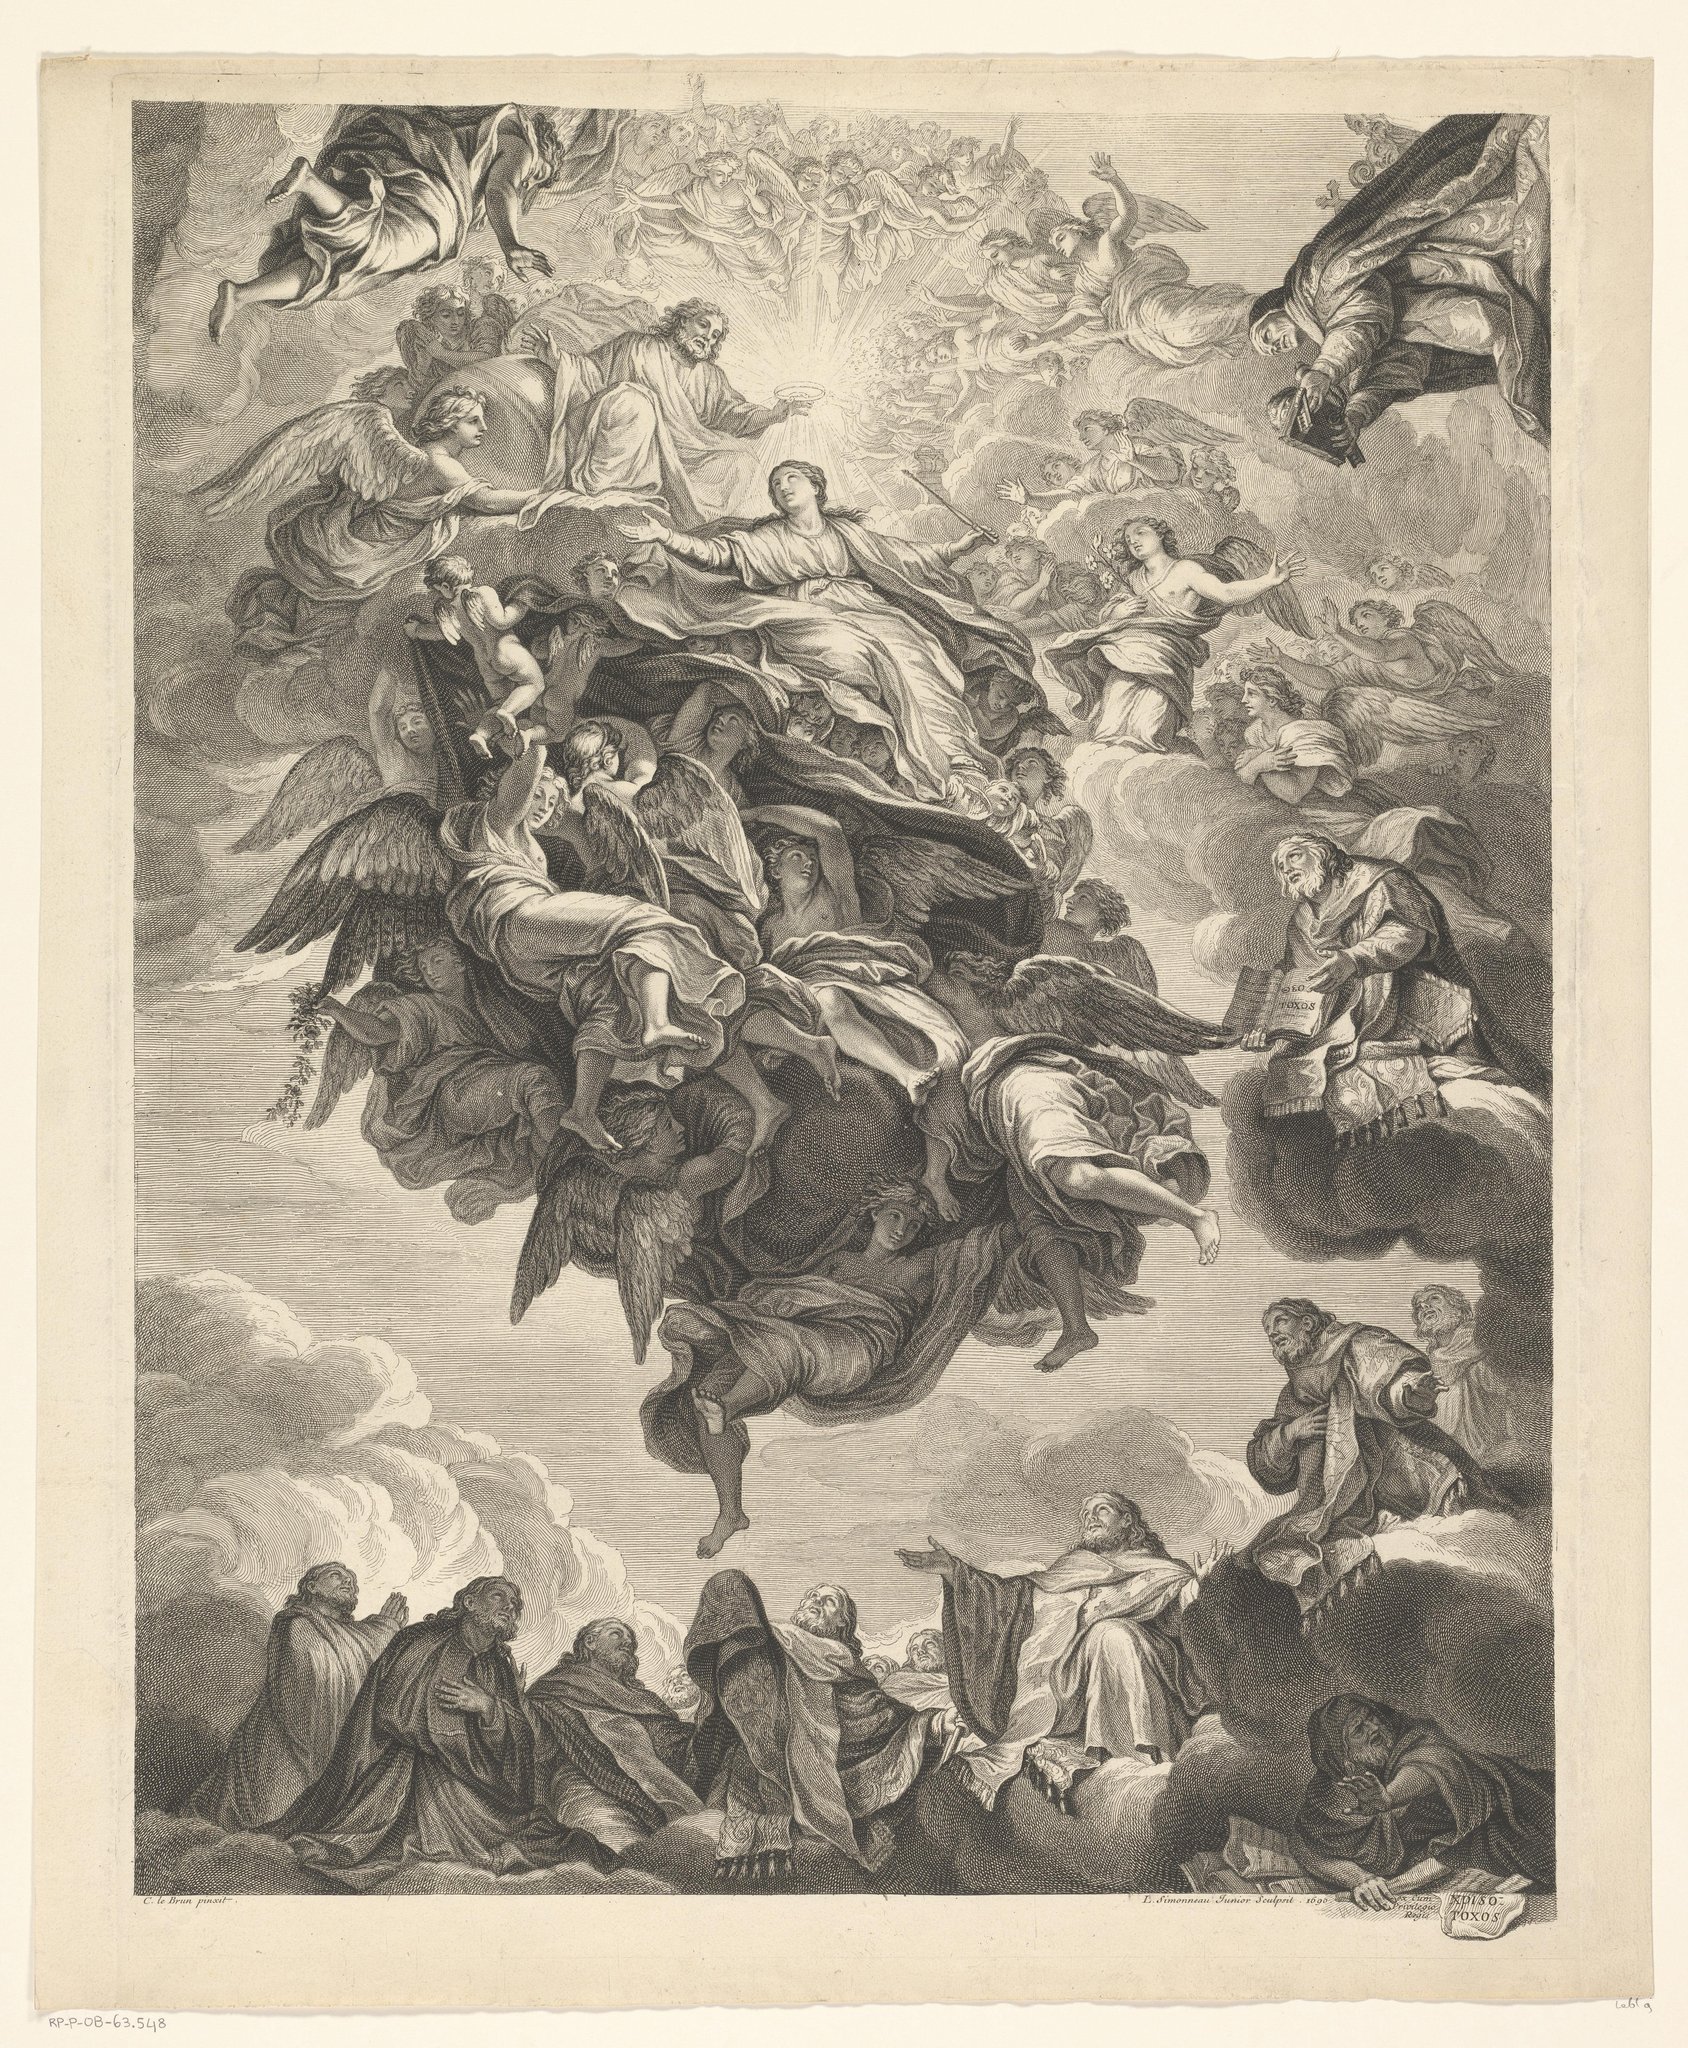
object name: print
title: Triomf van Maria over ketterij (bovenste deel)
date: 1690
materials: paper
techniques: etching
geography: france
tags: coronation of mary by god the father, the assumption of mary ('assumptio corporis'): she is borne into heaven by angels, heresy; 'heresia' (ripa)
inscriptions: collector's mark: Lugt 240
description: De triomf van Maria over de ketterij van Nestorius. Zij wordt door engelen ten hemel gedragen. Onder haar de geestelijken die vochten tegen de ketterij en rechts Nestorius zelf, die wordt verzwolgen door donkere wolken.